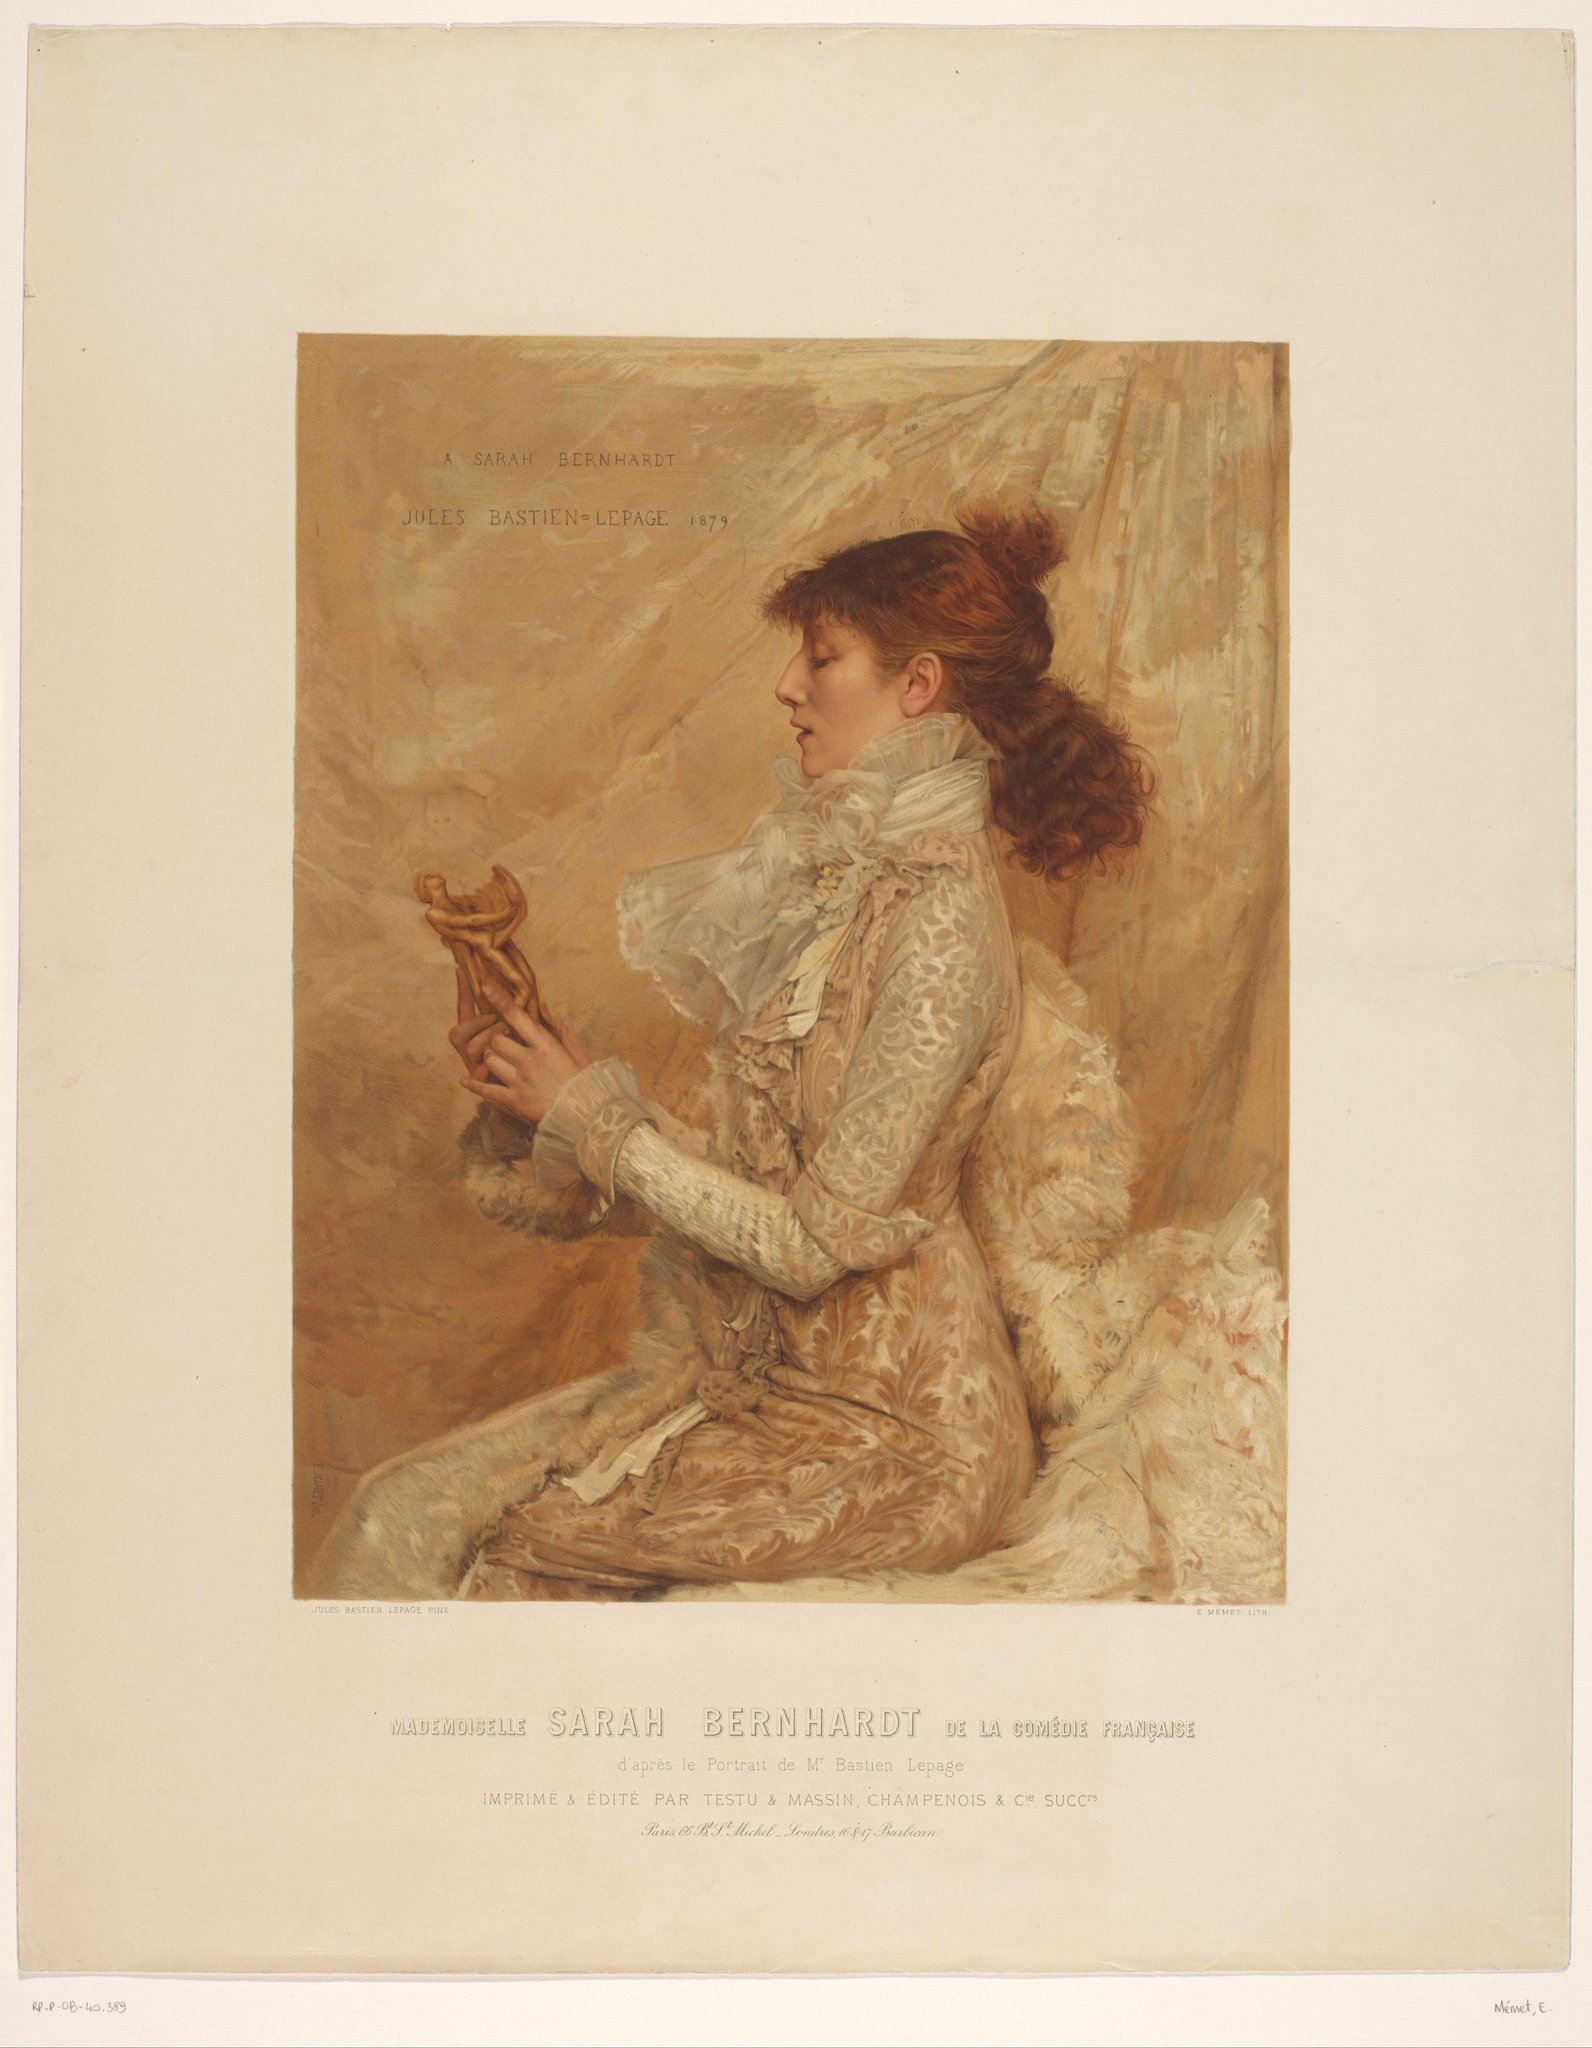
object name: print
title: Mademoiselle Sarah Bernhardt de la comédie française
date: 1879-1886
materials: paper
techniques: lithograph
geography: london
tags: paris, sarah bernhardt, historical persons, historical costume, sculpture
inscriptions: collector's mark: Lugt 2228